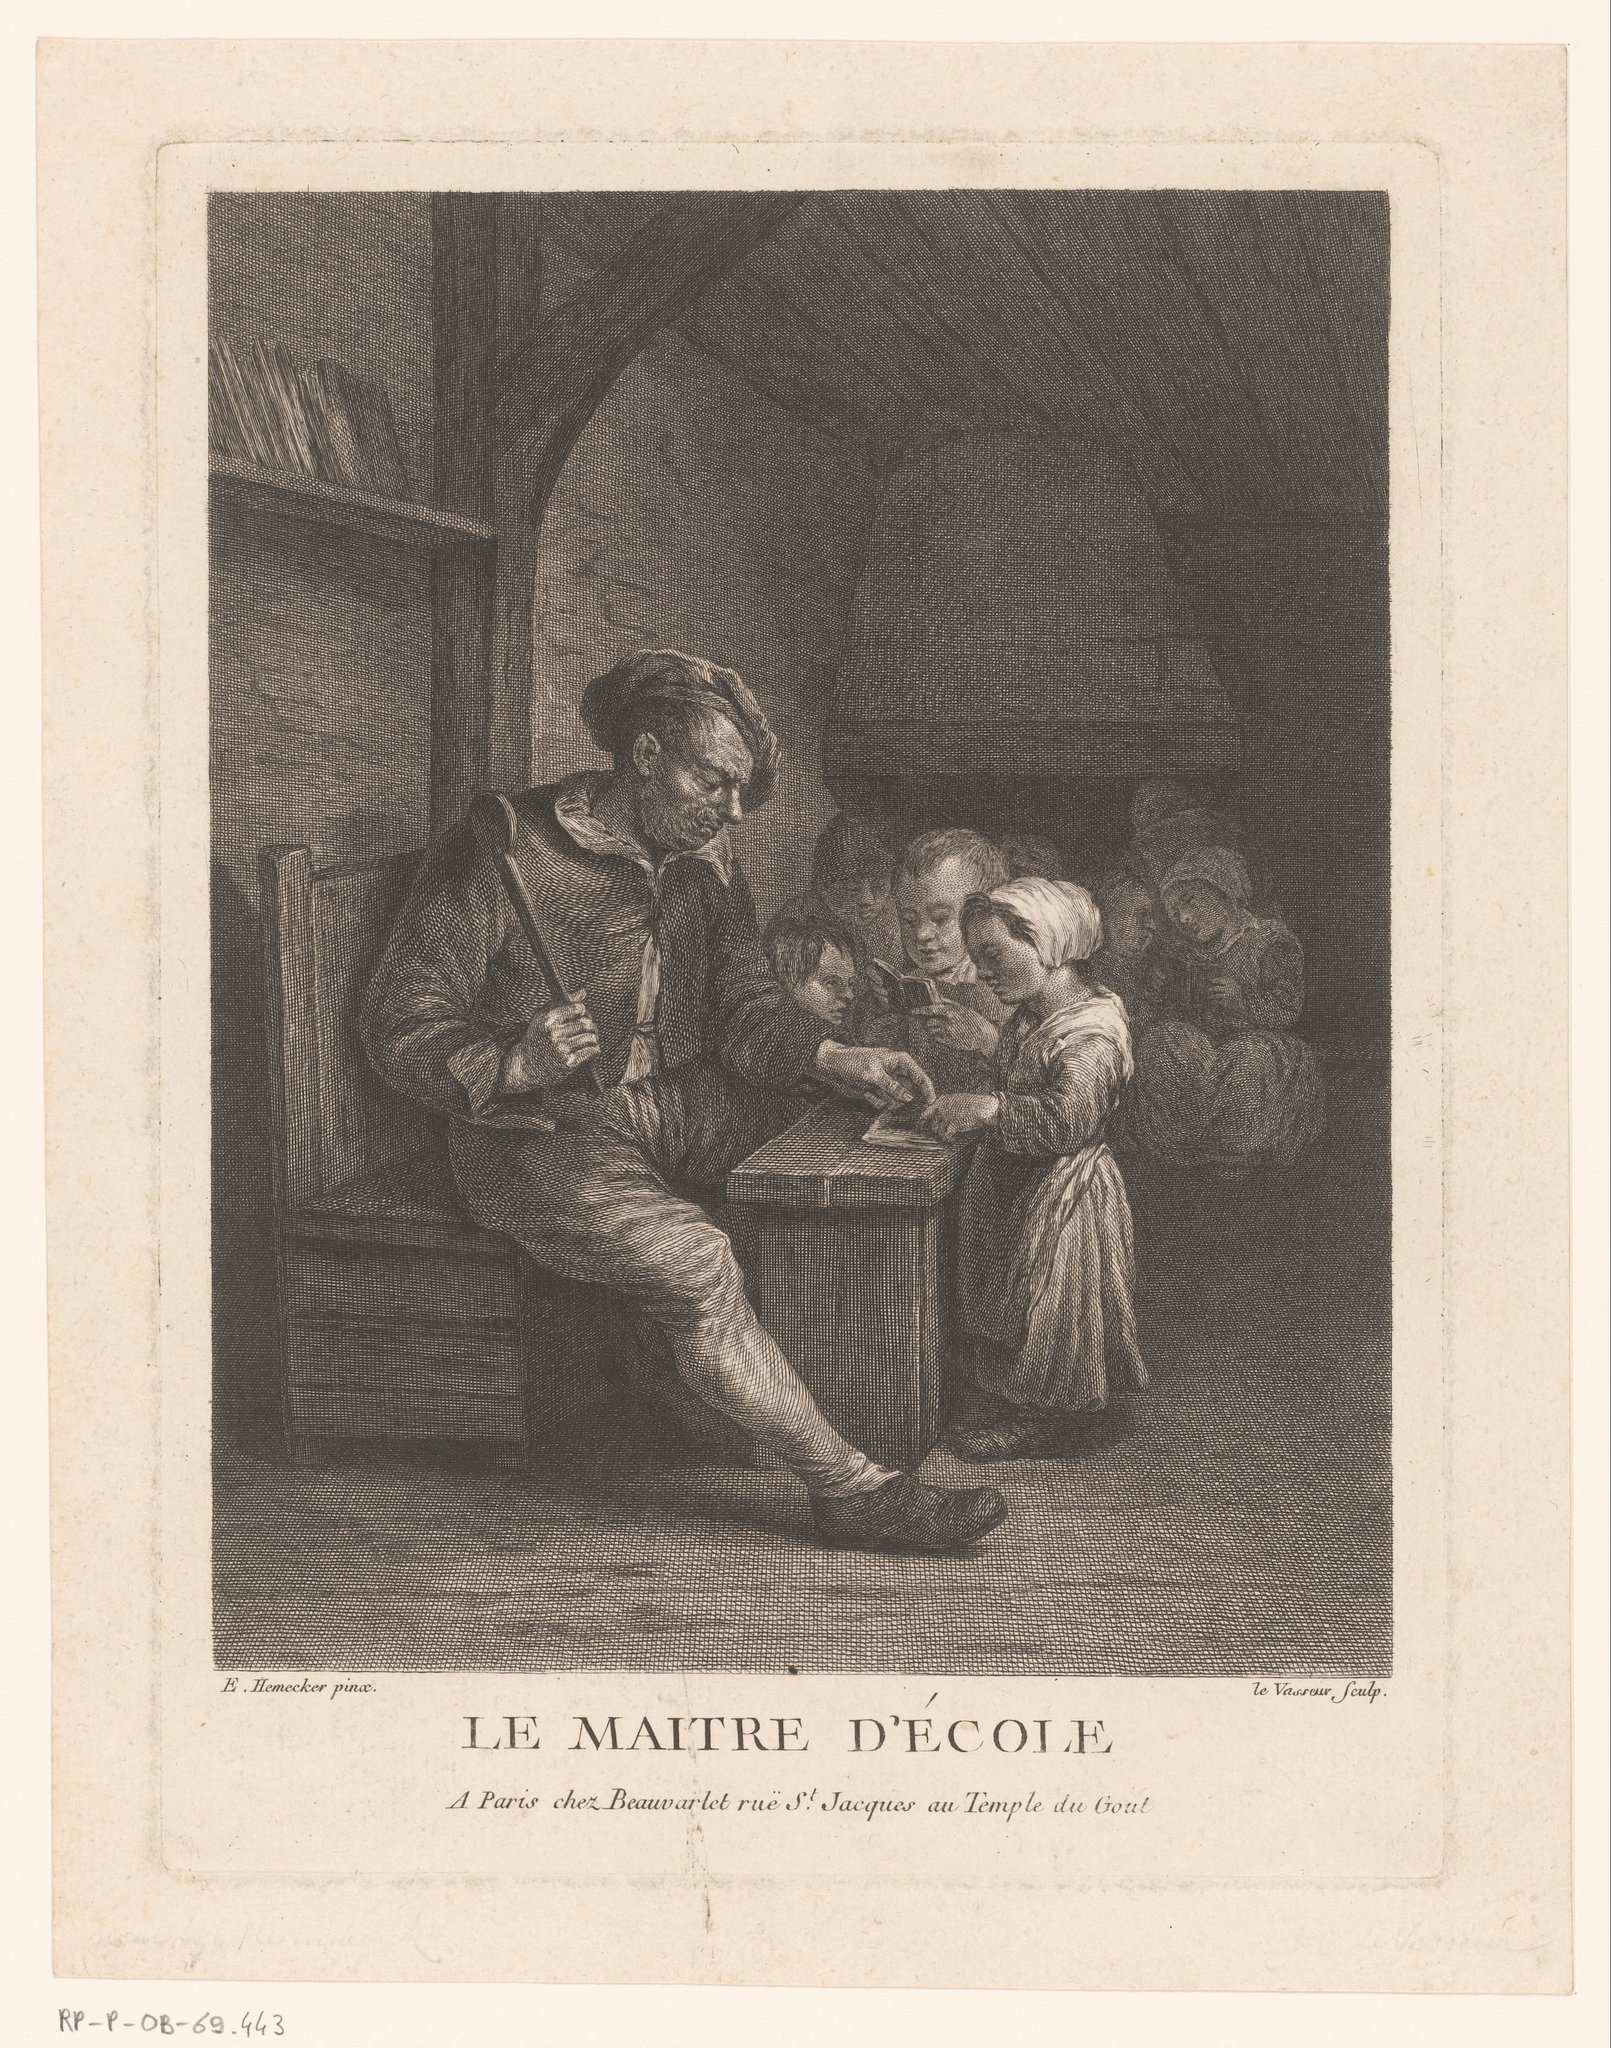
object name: print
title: Le Maitre d'école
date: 1744-1797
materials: paper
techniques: engraving, etching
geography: paris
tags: teacher and pupil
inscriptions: collector's mark: Lugt 2228